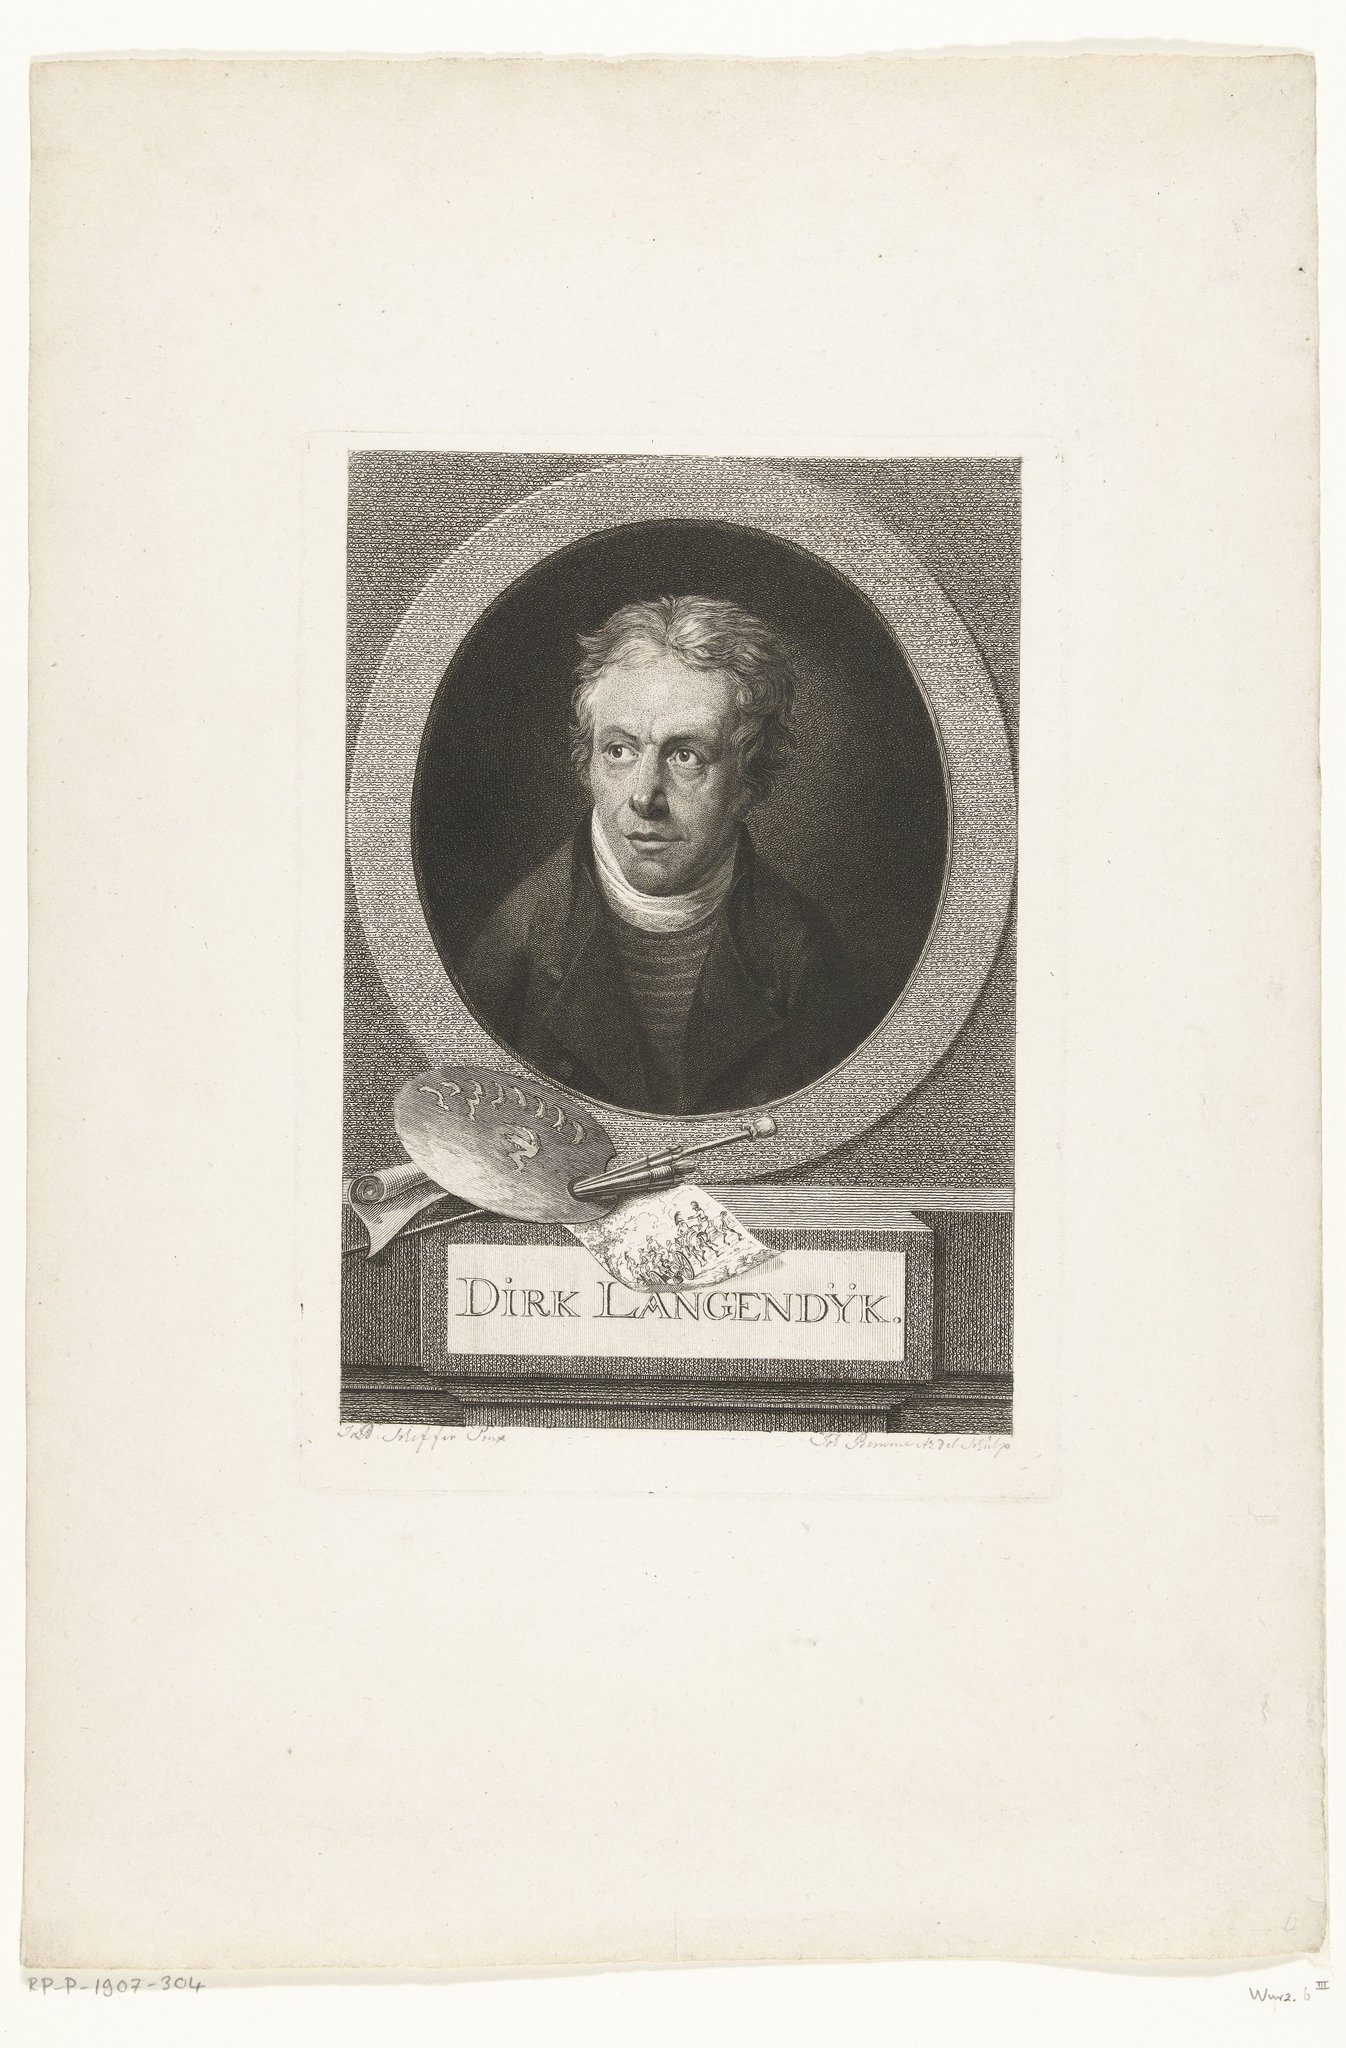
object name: print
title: Portret van Dirk van Langendijk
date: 1805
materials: paper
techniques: etching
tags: rotterdam, painter, print maker, draughtsman, dirk langendijk, art (+ portrait, self-portrait of artist)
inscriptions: collector's mark: Lugt 2228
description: Portret van de kunstenaar Dirk van Langendijk met palet, penselen en tekening.